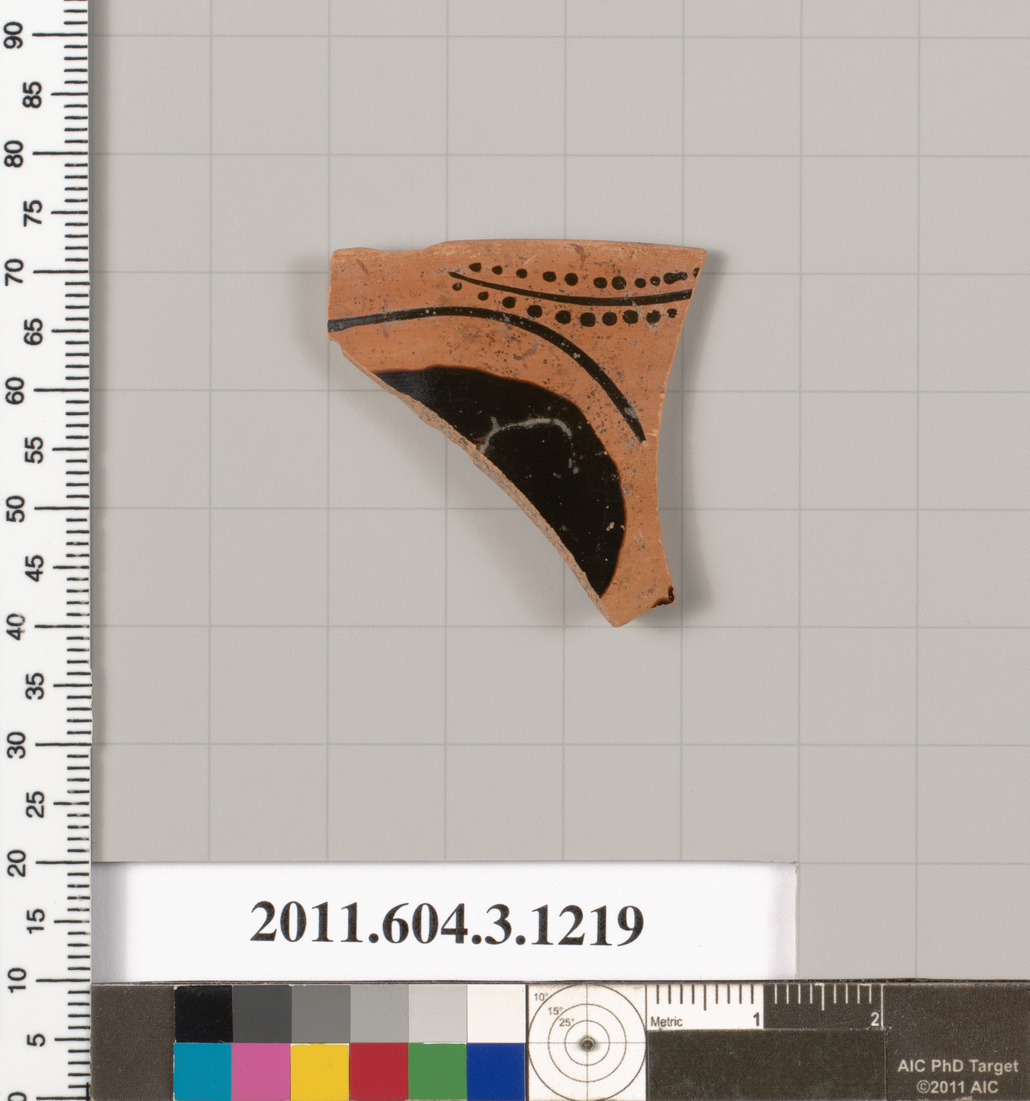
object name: kyathos fragment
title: Terracotta rim fragment of a kyathos (cup-shaped ladle)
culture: greek, attic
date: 534-468 BCE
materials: terracotta